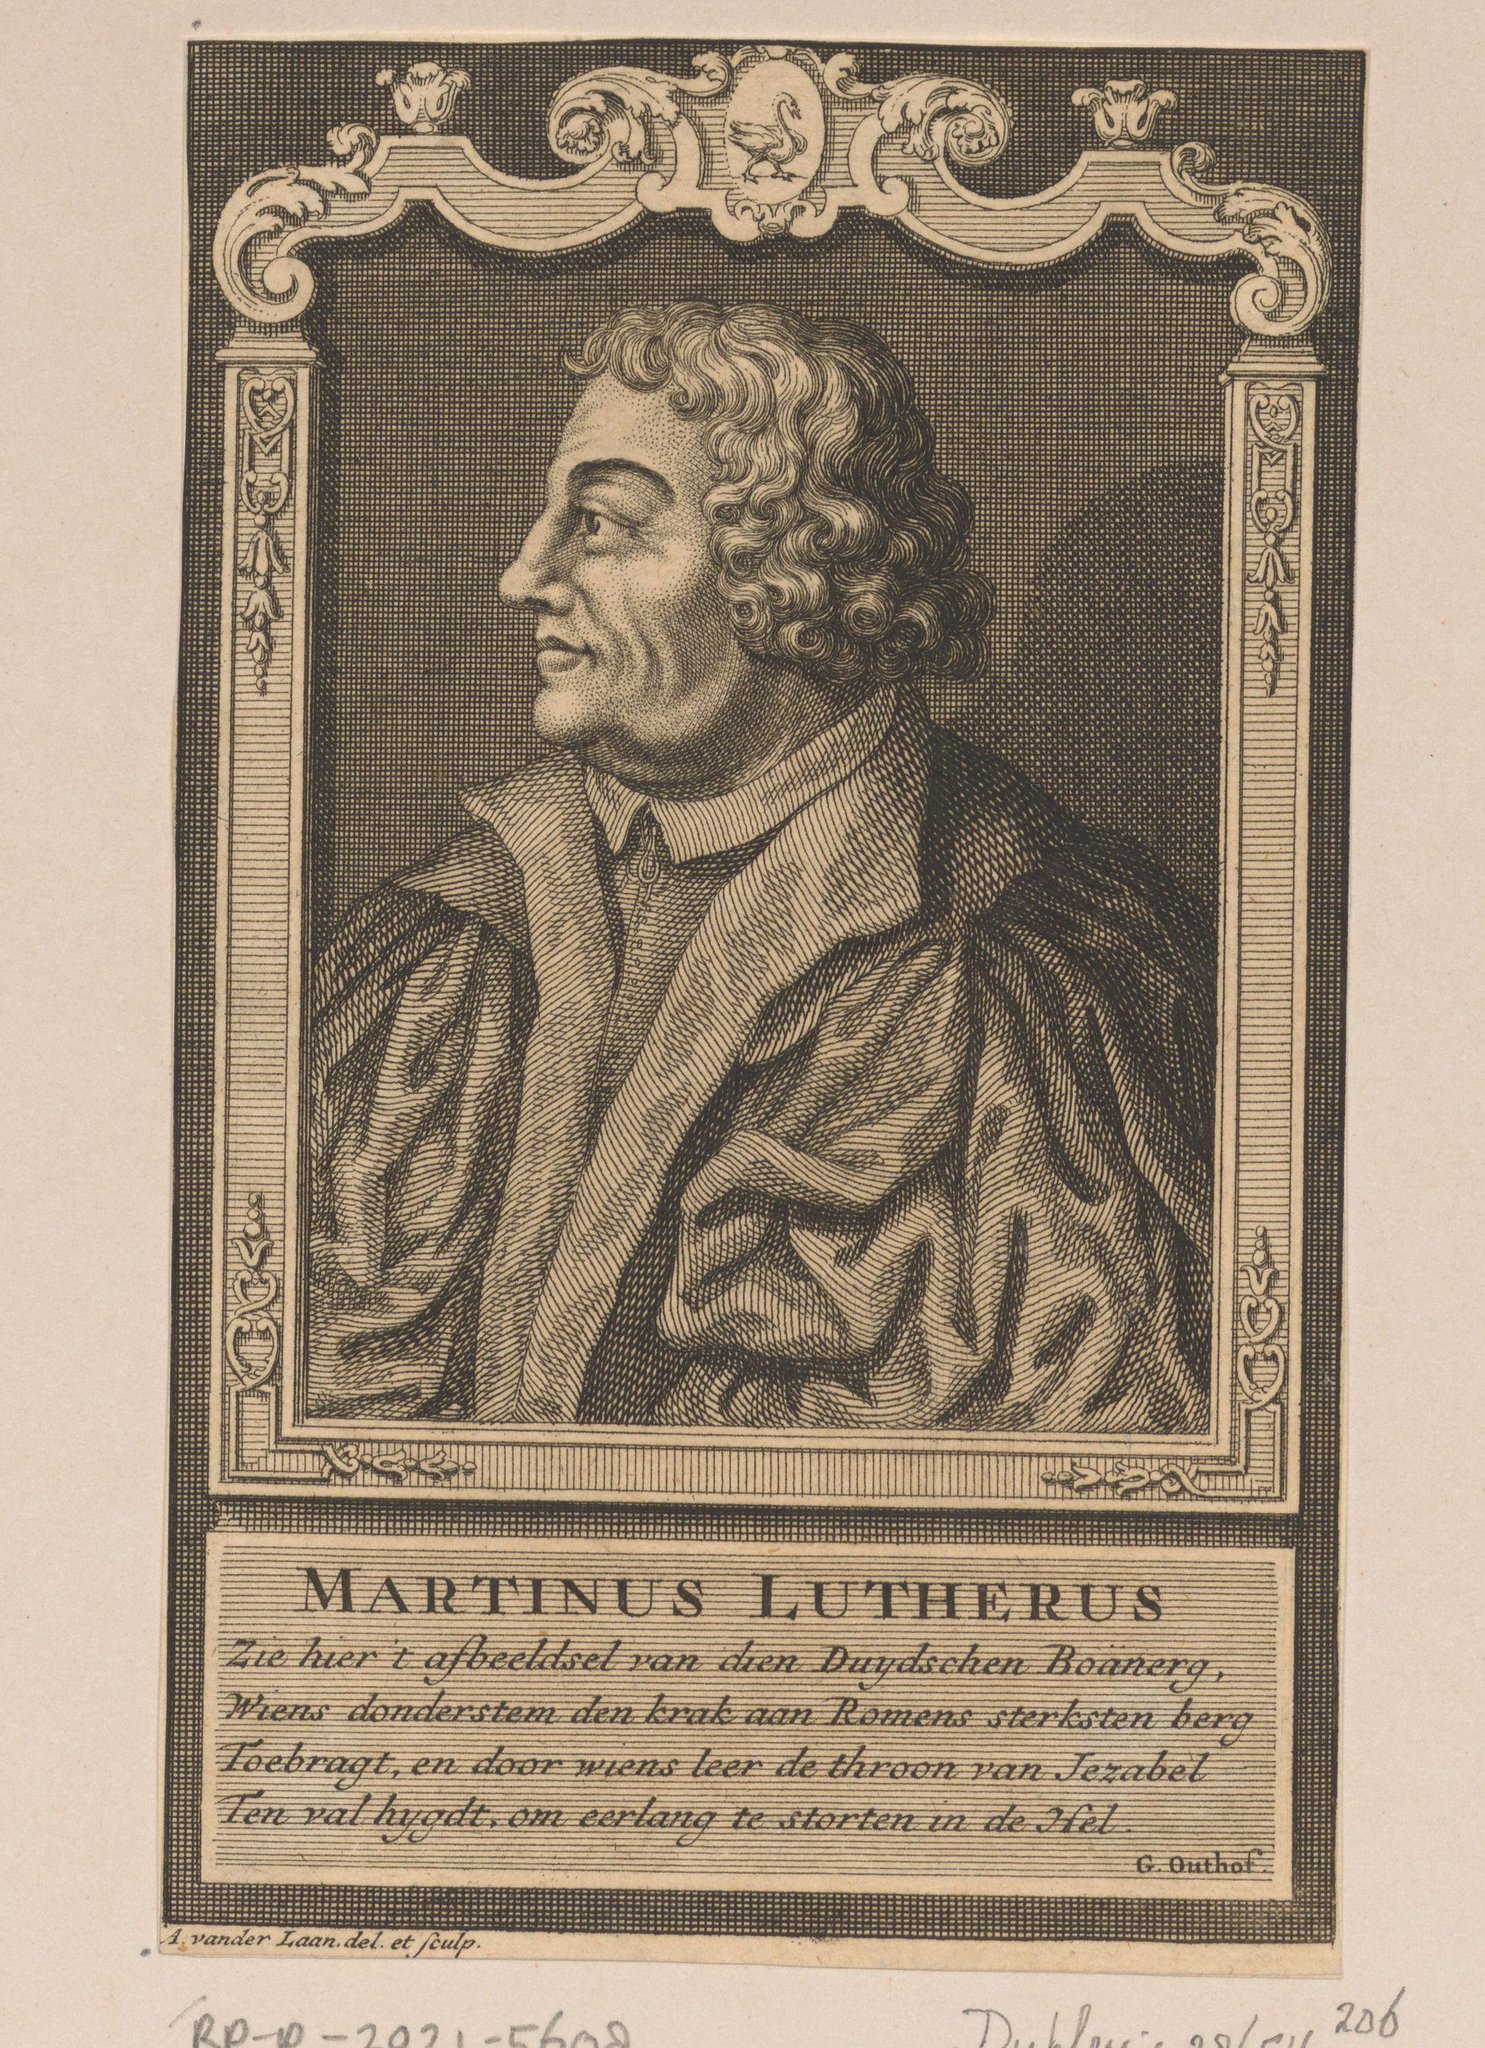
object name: print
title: Portret van Martin Luther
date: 1731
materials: paper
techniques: etching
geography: amsterdam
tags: priest, martin luther, theologian, water-birds: swan, historical persons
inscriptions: number: ‘1365’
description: Prent waarschijnlijk uit: Outhof, Gerardus. Levensbeschryving van beroemde en geleerde mannen (...). Amsterdam: Adriaan Wor en erven Onder de Linden, 1731, dl. 4-10.